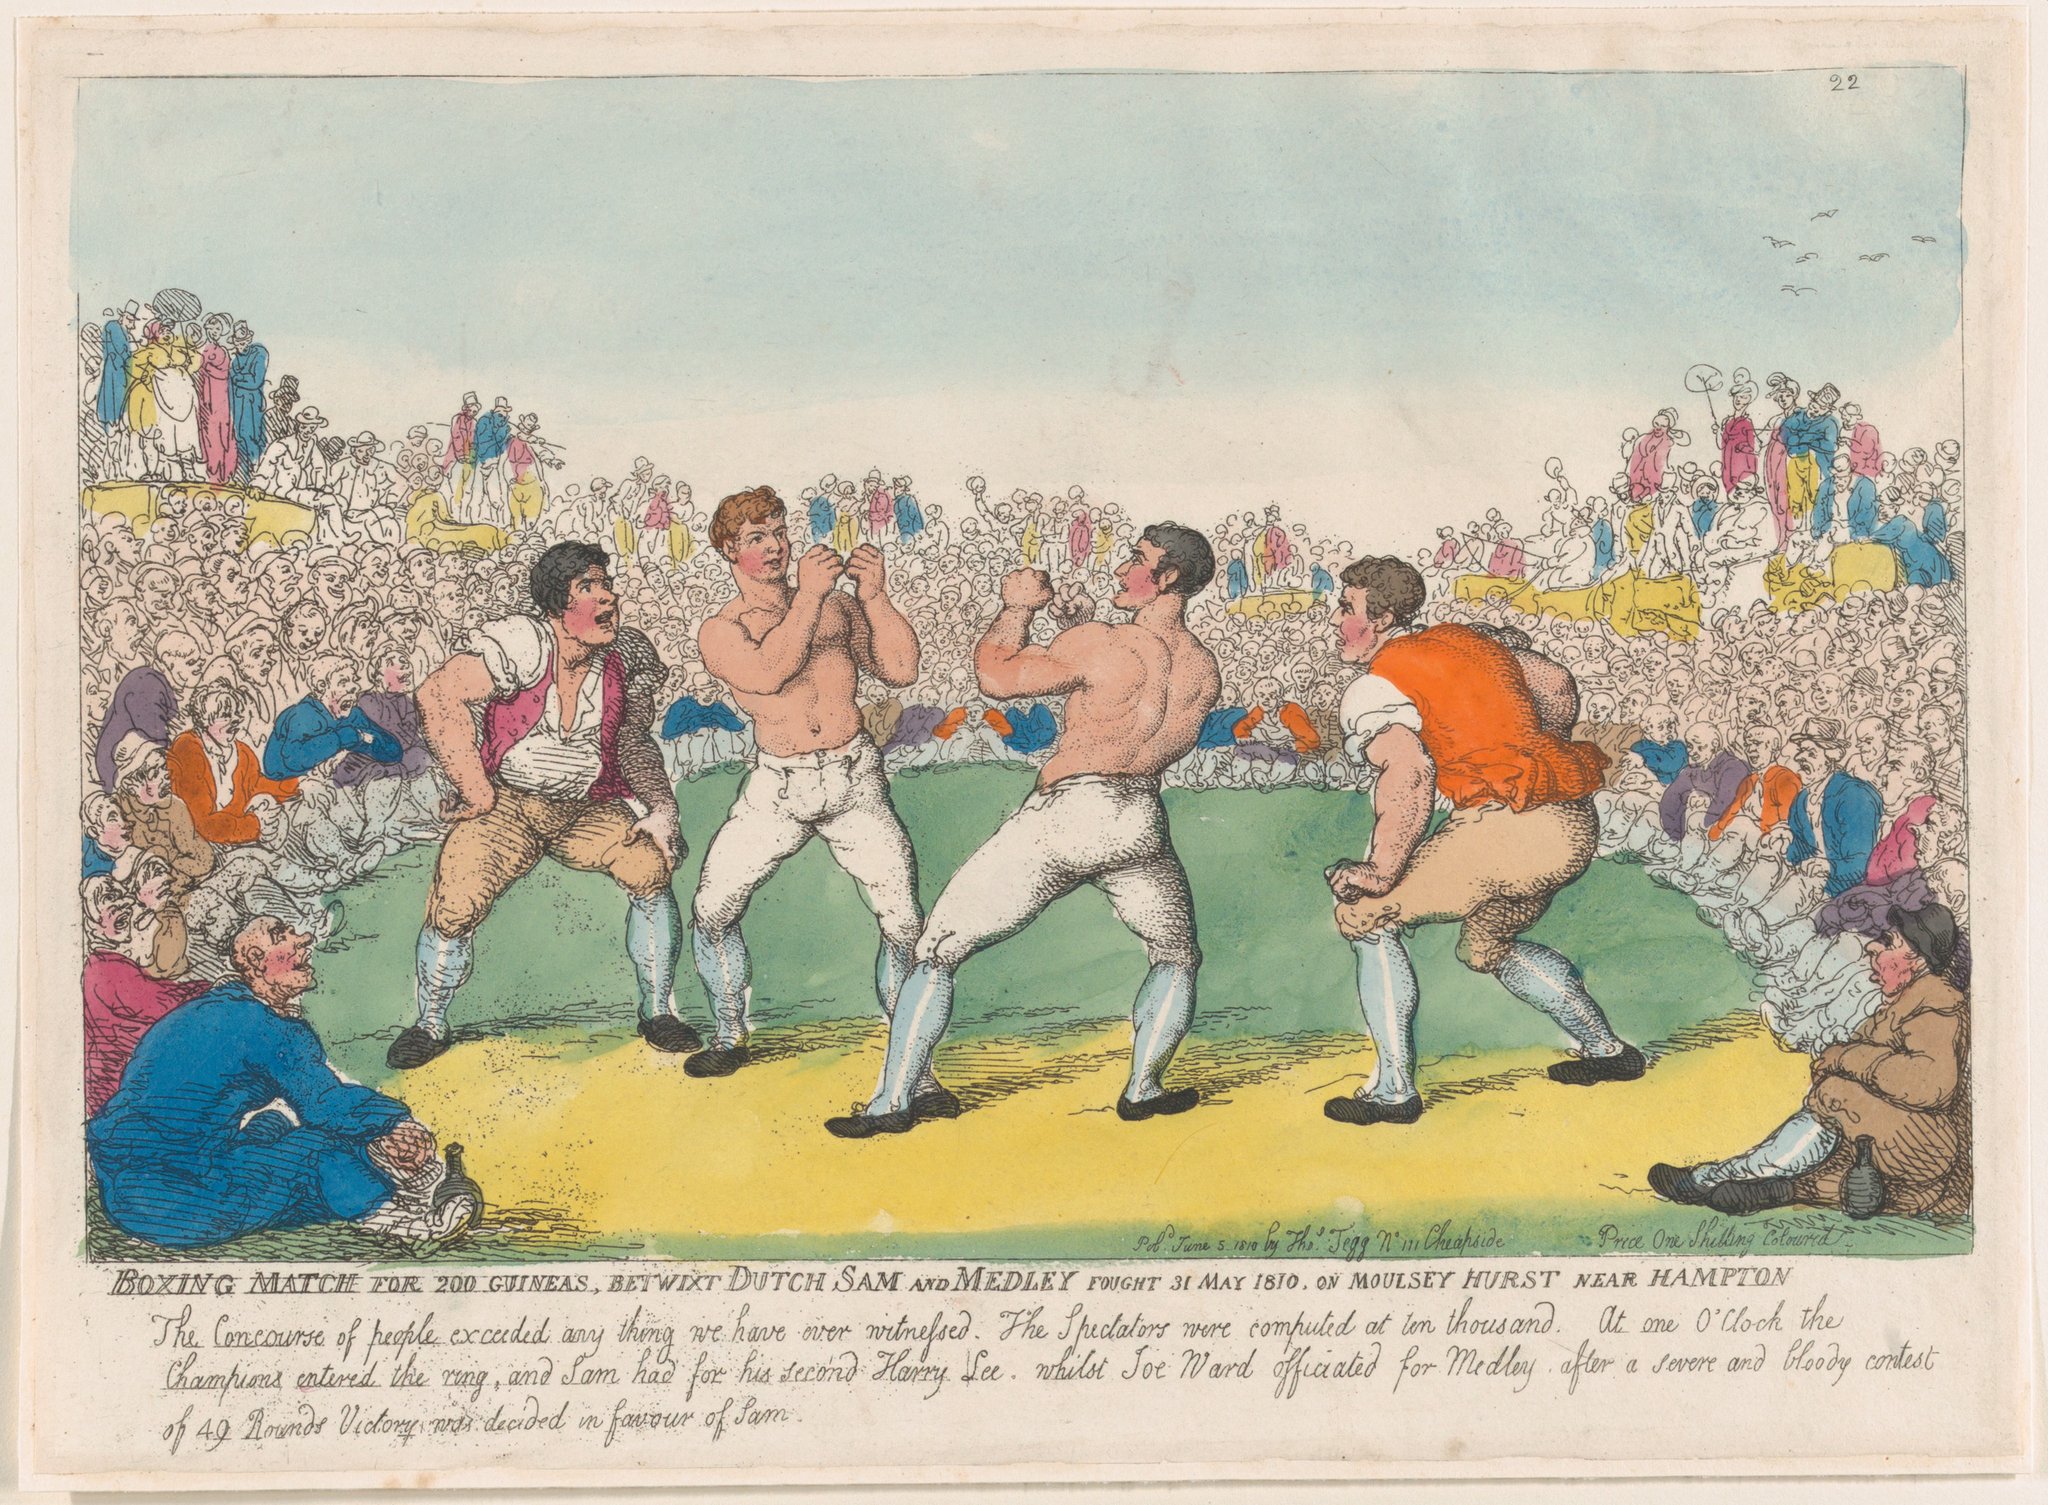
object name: print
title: Boxing Match for 200 Guineas, Betwixt Dutch Sam and Medley Fought 31 May 1810, on Moulsey Hurst Near Hampton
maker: thomas rowlandson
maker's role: artist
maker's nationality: british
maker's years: 1757-1827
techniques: etching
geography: london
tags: men,spectators,boxing,athletes